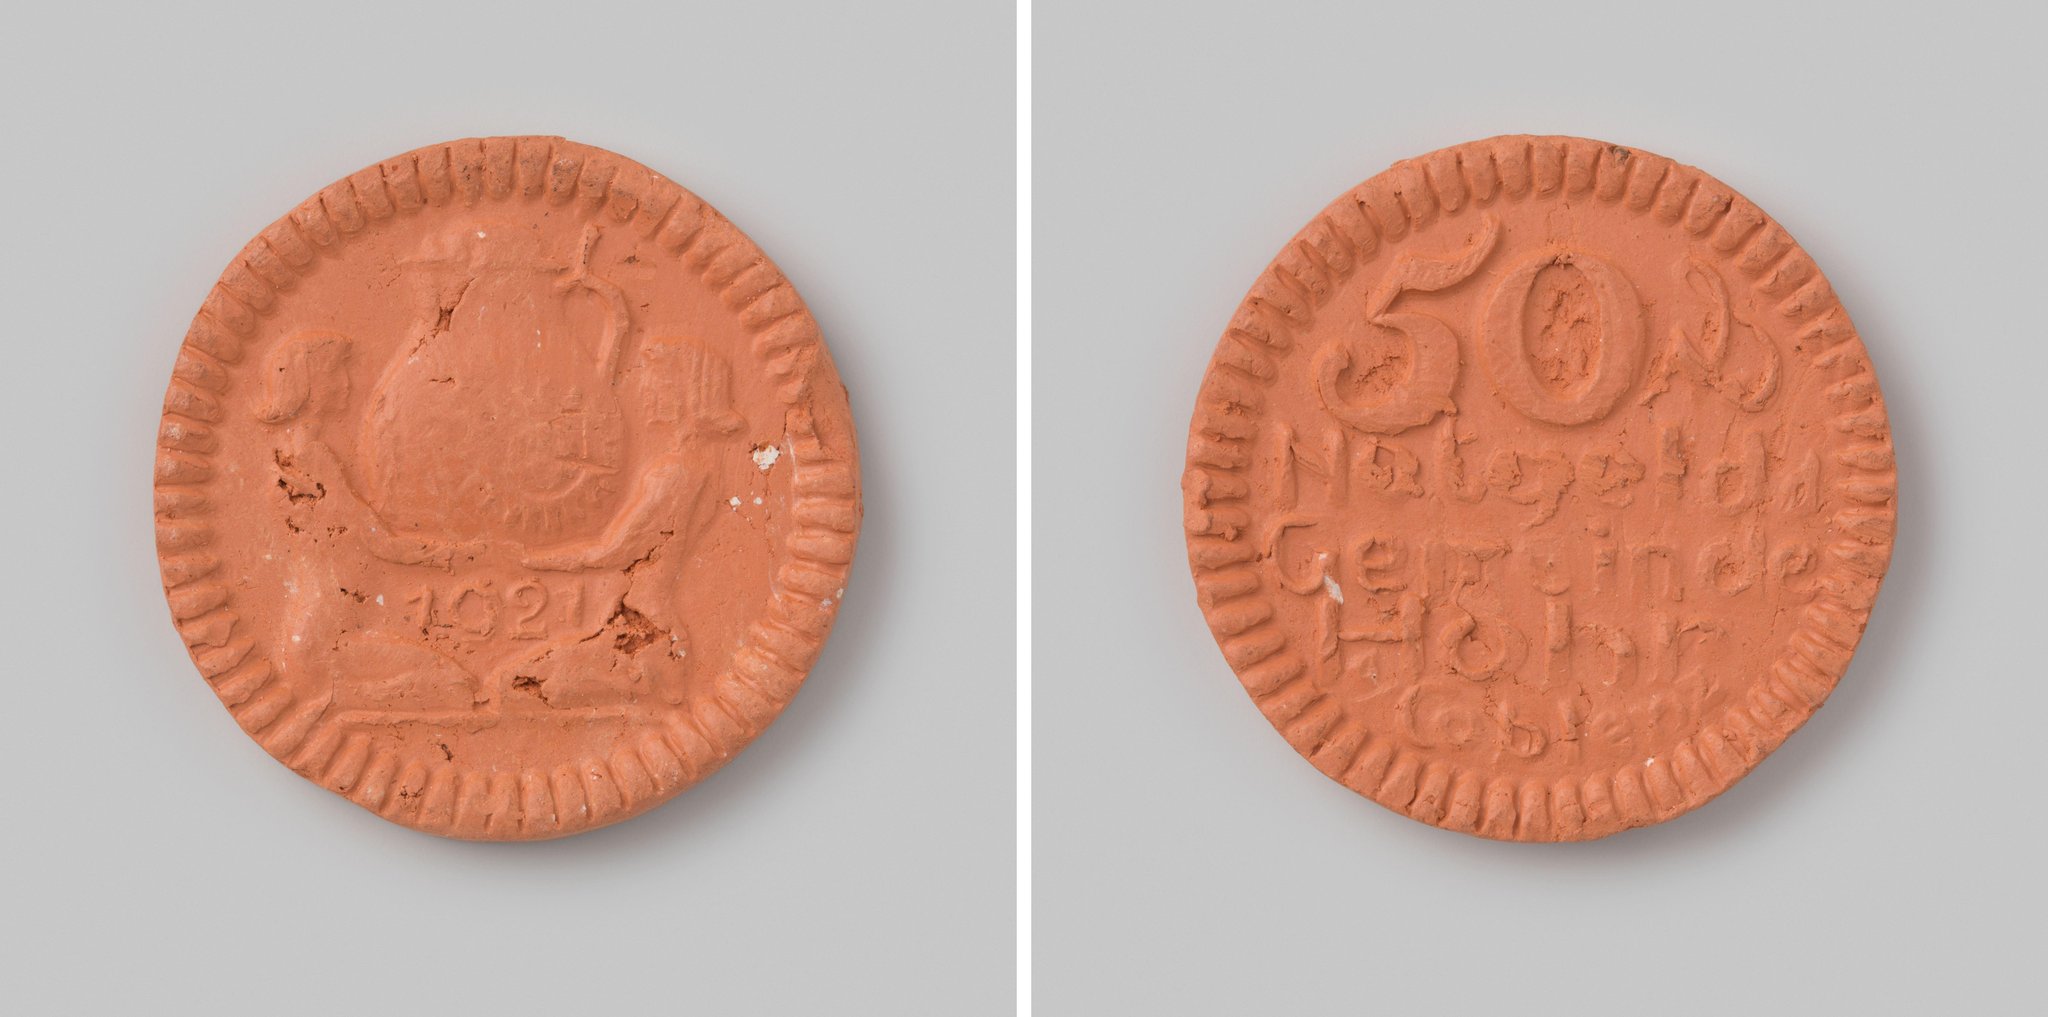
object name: coin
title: 50 mark notgeld uit Duitsland, Höhr, Coblenz, 1921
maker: a. kamp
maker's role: sculptor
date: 1921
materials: porcelain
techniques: casting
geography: höhr-grenzhausen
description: Porseleinen rood gekleurde pseudomunt. Voorzijde: jongen en meisje die een schenkkan dragen. Tussen beiden jaartal. Keerzijde: waarde-aanduiding in twee regels, waaronder plaats-aanduiding in drie regels. Gladde rand.